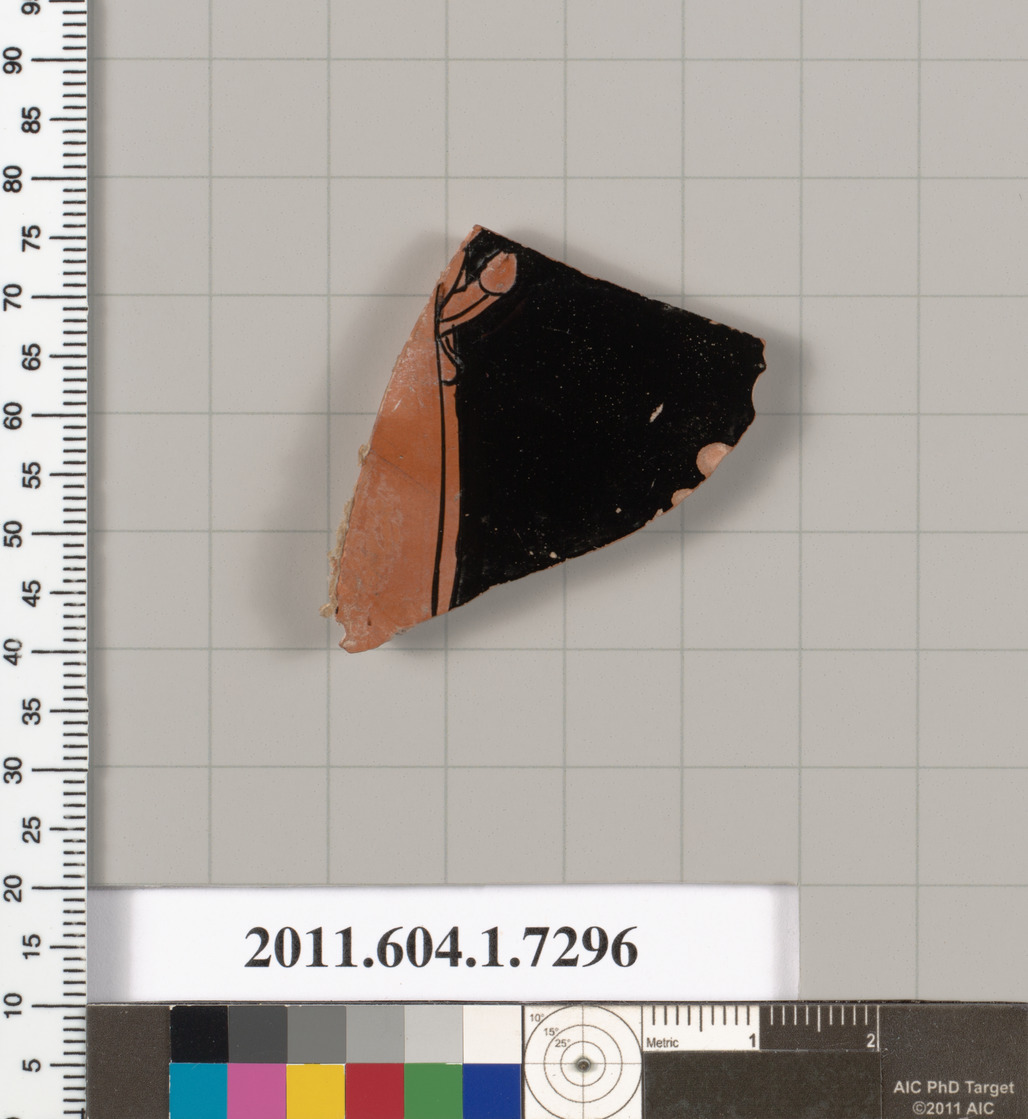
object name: kylix fragment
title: Terracotta fragment of a kylix (drinking cup)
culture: greek, attic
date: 500-480 BCE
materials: terracotta